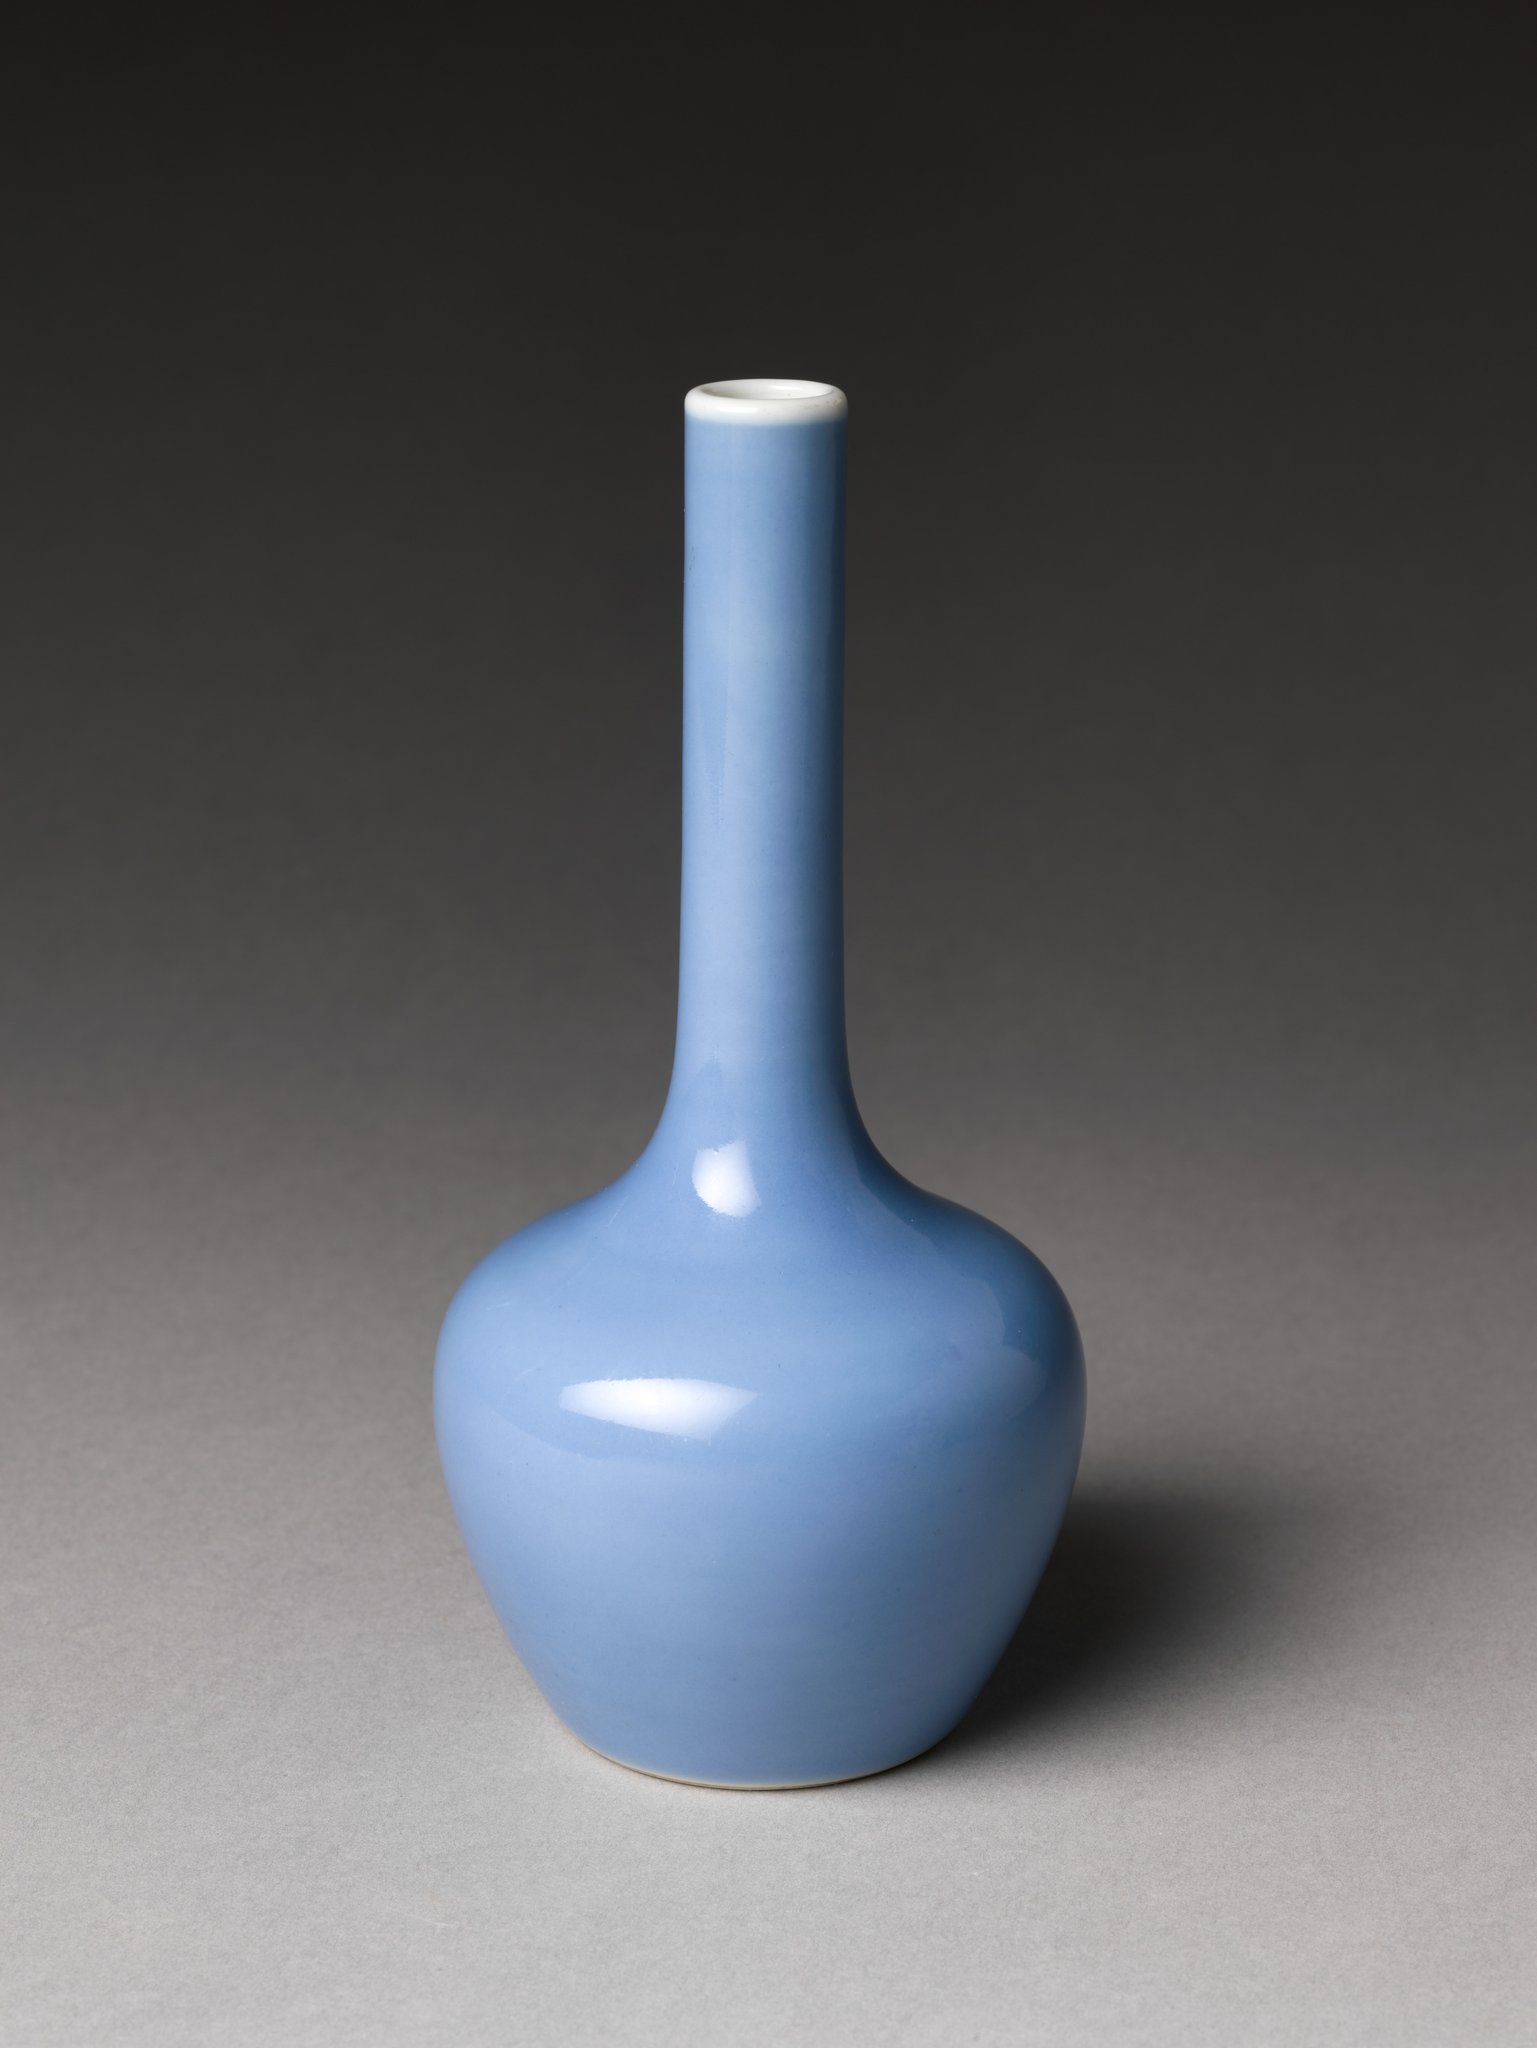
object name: vase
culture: chinese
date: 1701-1733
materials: glaze, porcelain